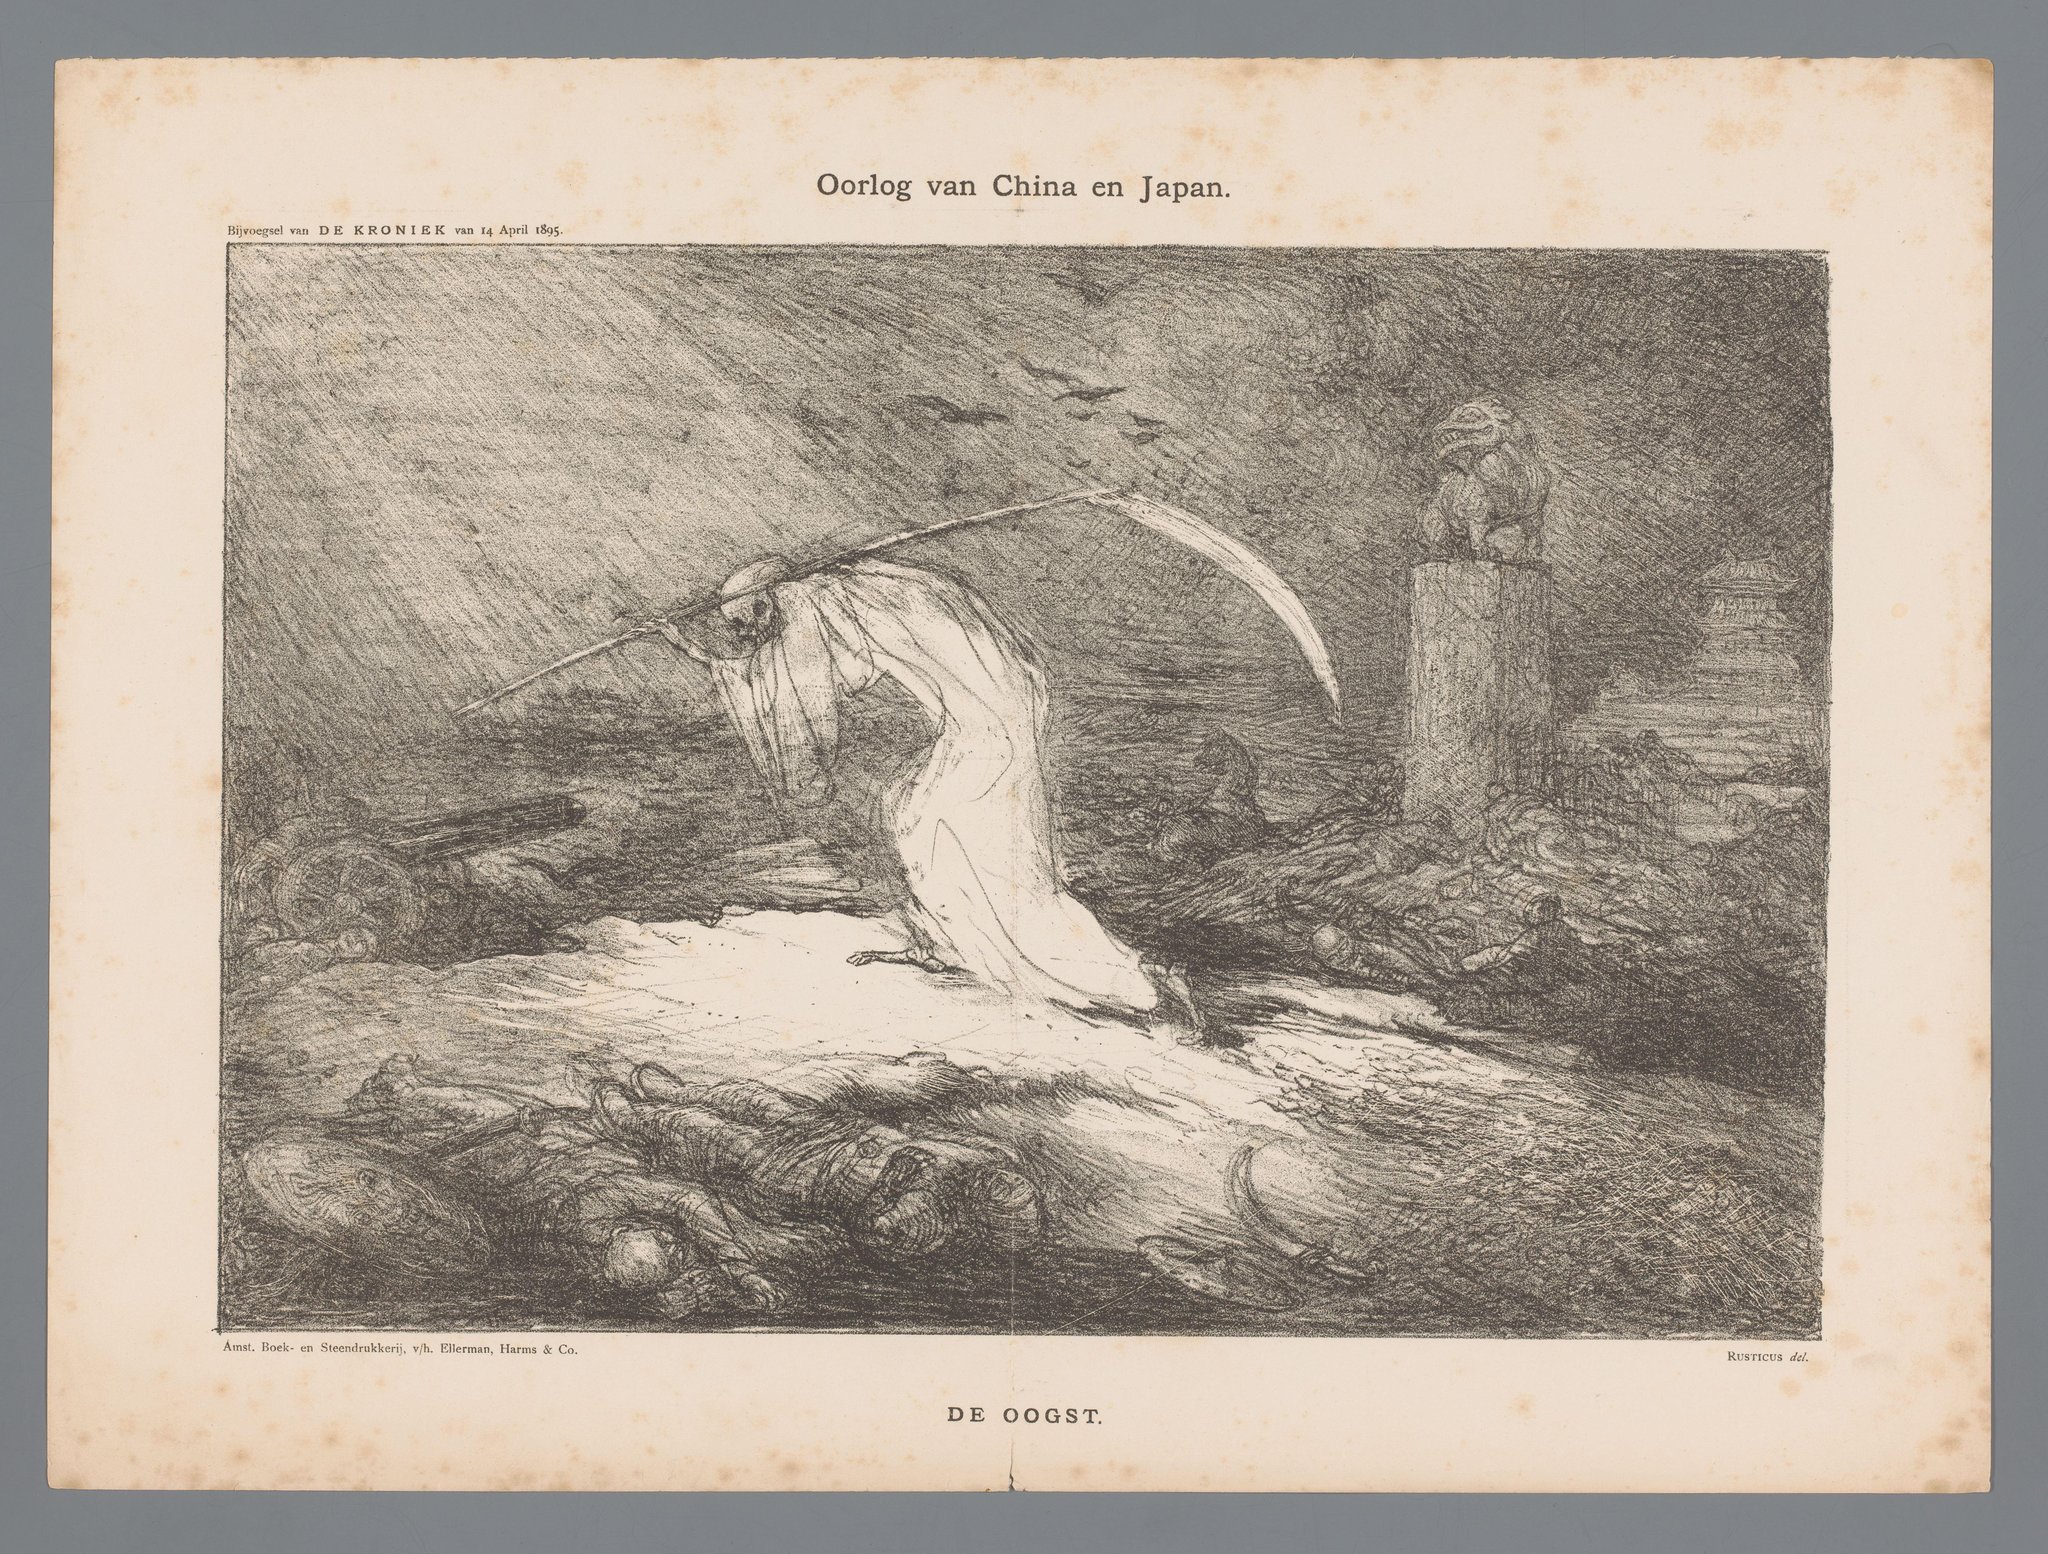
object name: cartoon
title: Oorlog van China en Japan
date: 1895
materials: paper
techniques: lithograph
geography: amsterdam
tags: death as skeleton, personifications of death; 'morte' (ripa) (+ death with scythe), political caricatures and satires, china, japan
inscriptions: date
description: Spotprent op de Eerste Chinees-Japanse Oorlog in 1894-1895. De Dood waart over het slagveld bezaaid met lijken. Verschenen in de bijvoegsel van 'De Kroniek' van 14 april 1895.